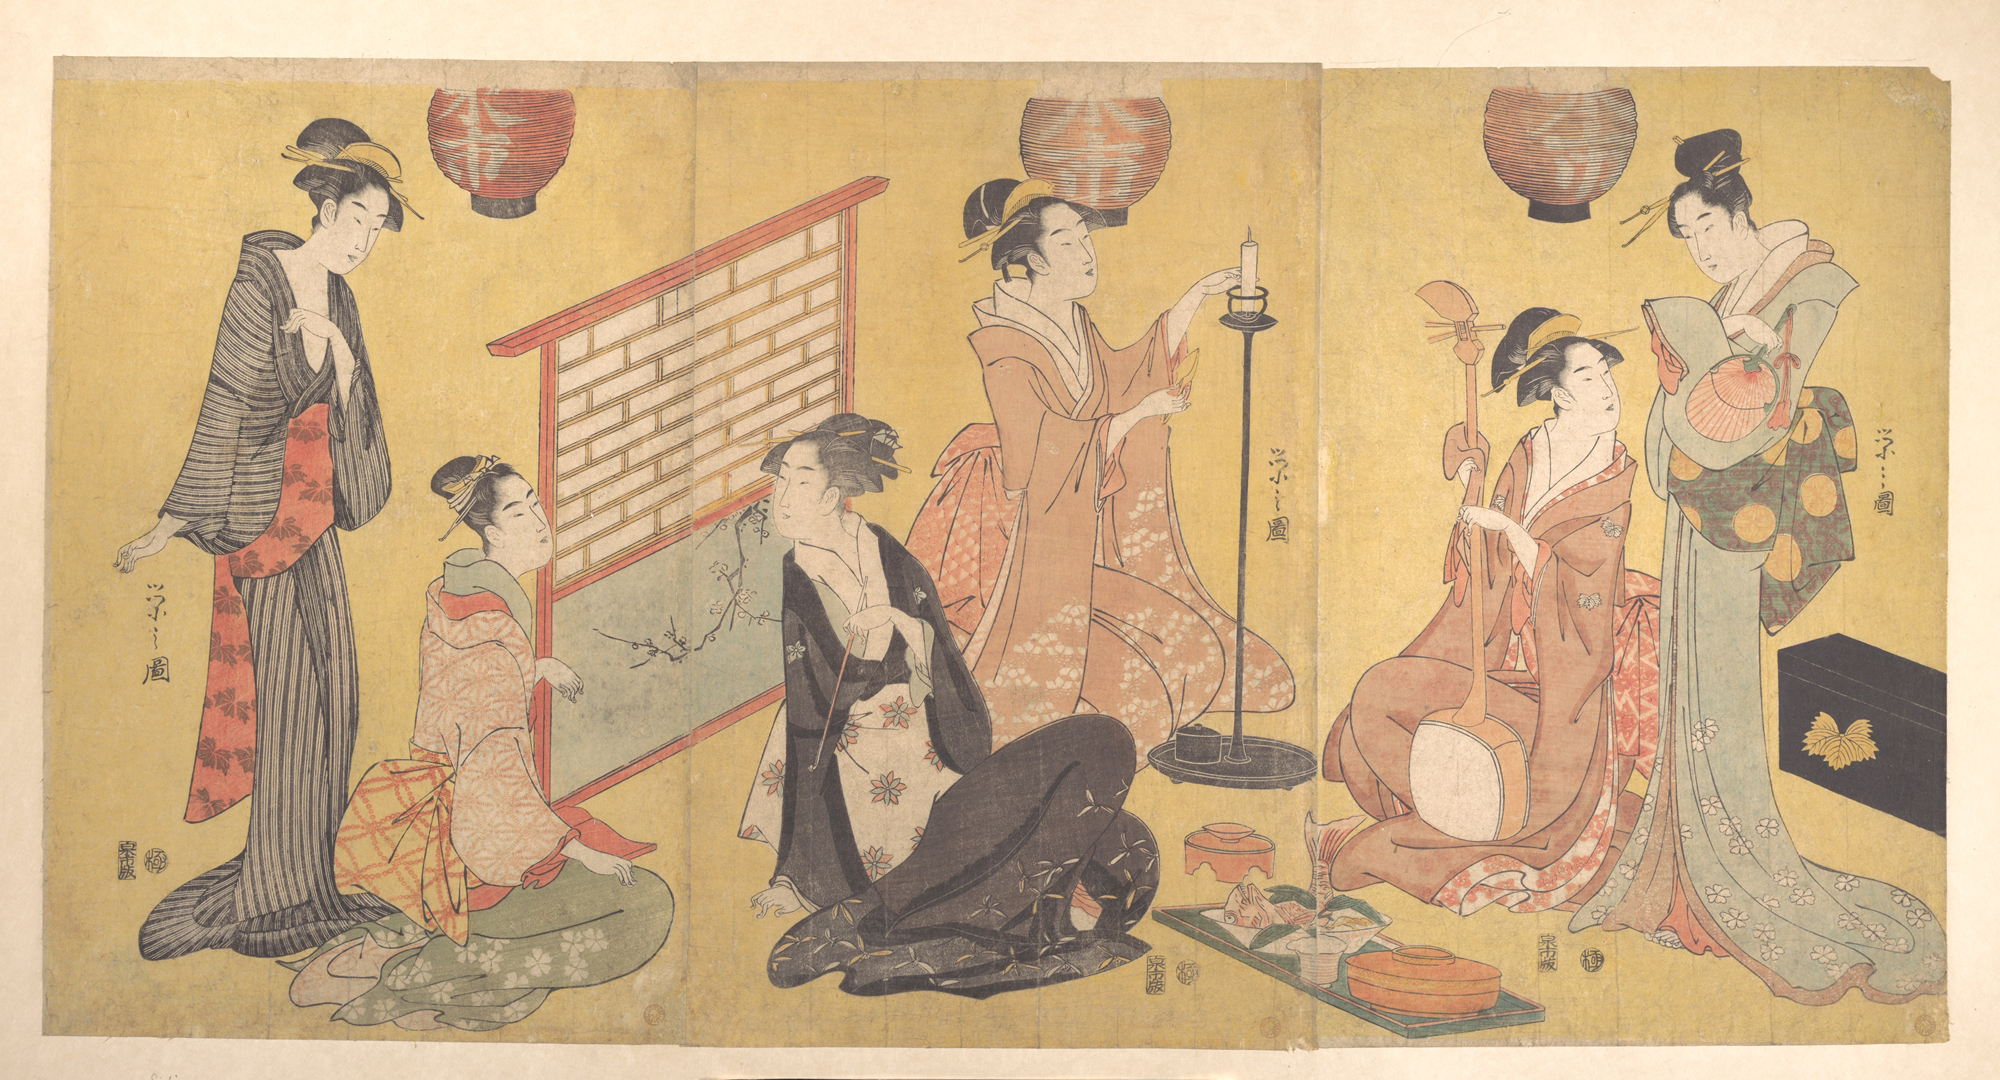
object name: print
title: Geisha Preparing for an Entertainment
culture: japanese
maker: chōbunsai eishi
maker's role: artist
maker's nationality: japanese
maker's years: 1756-1829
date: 1794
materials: ink, paper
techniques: woodblock print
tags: musical instruments,women